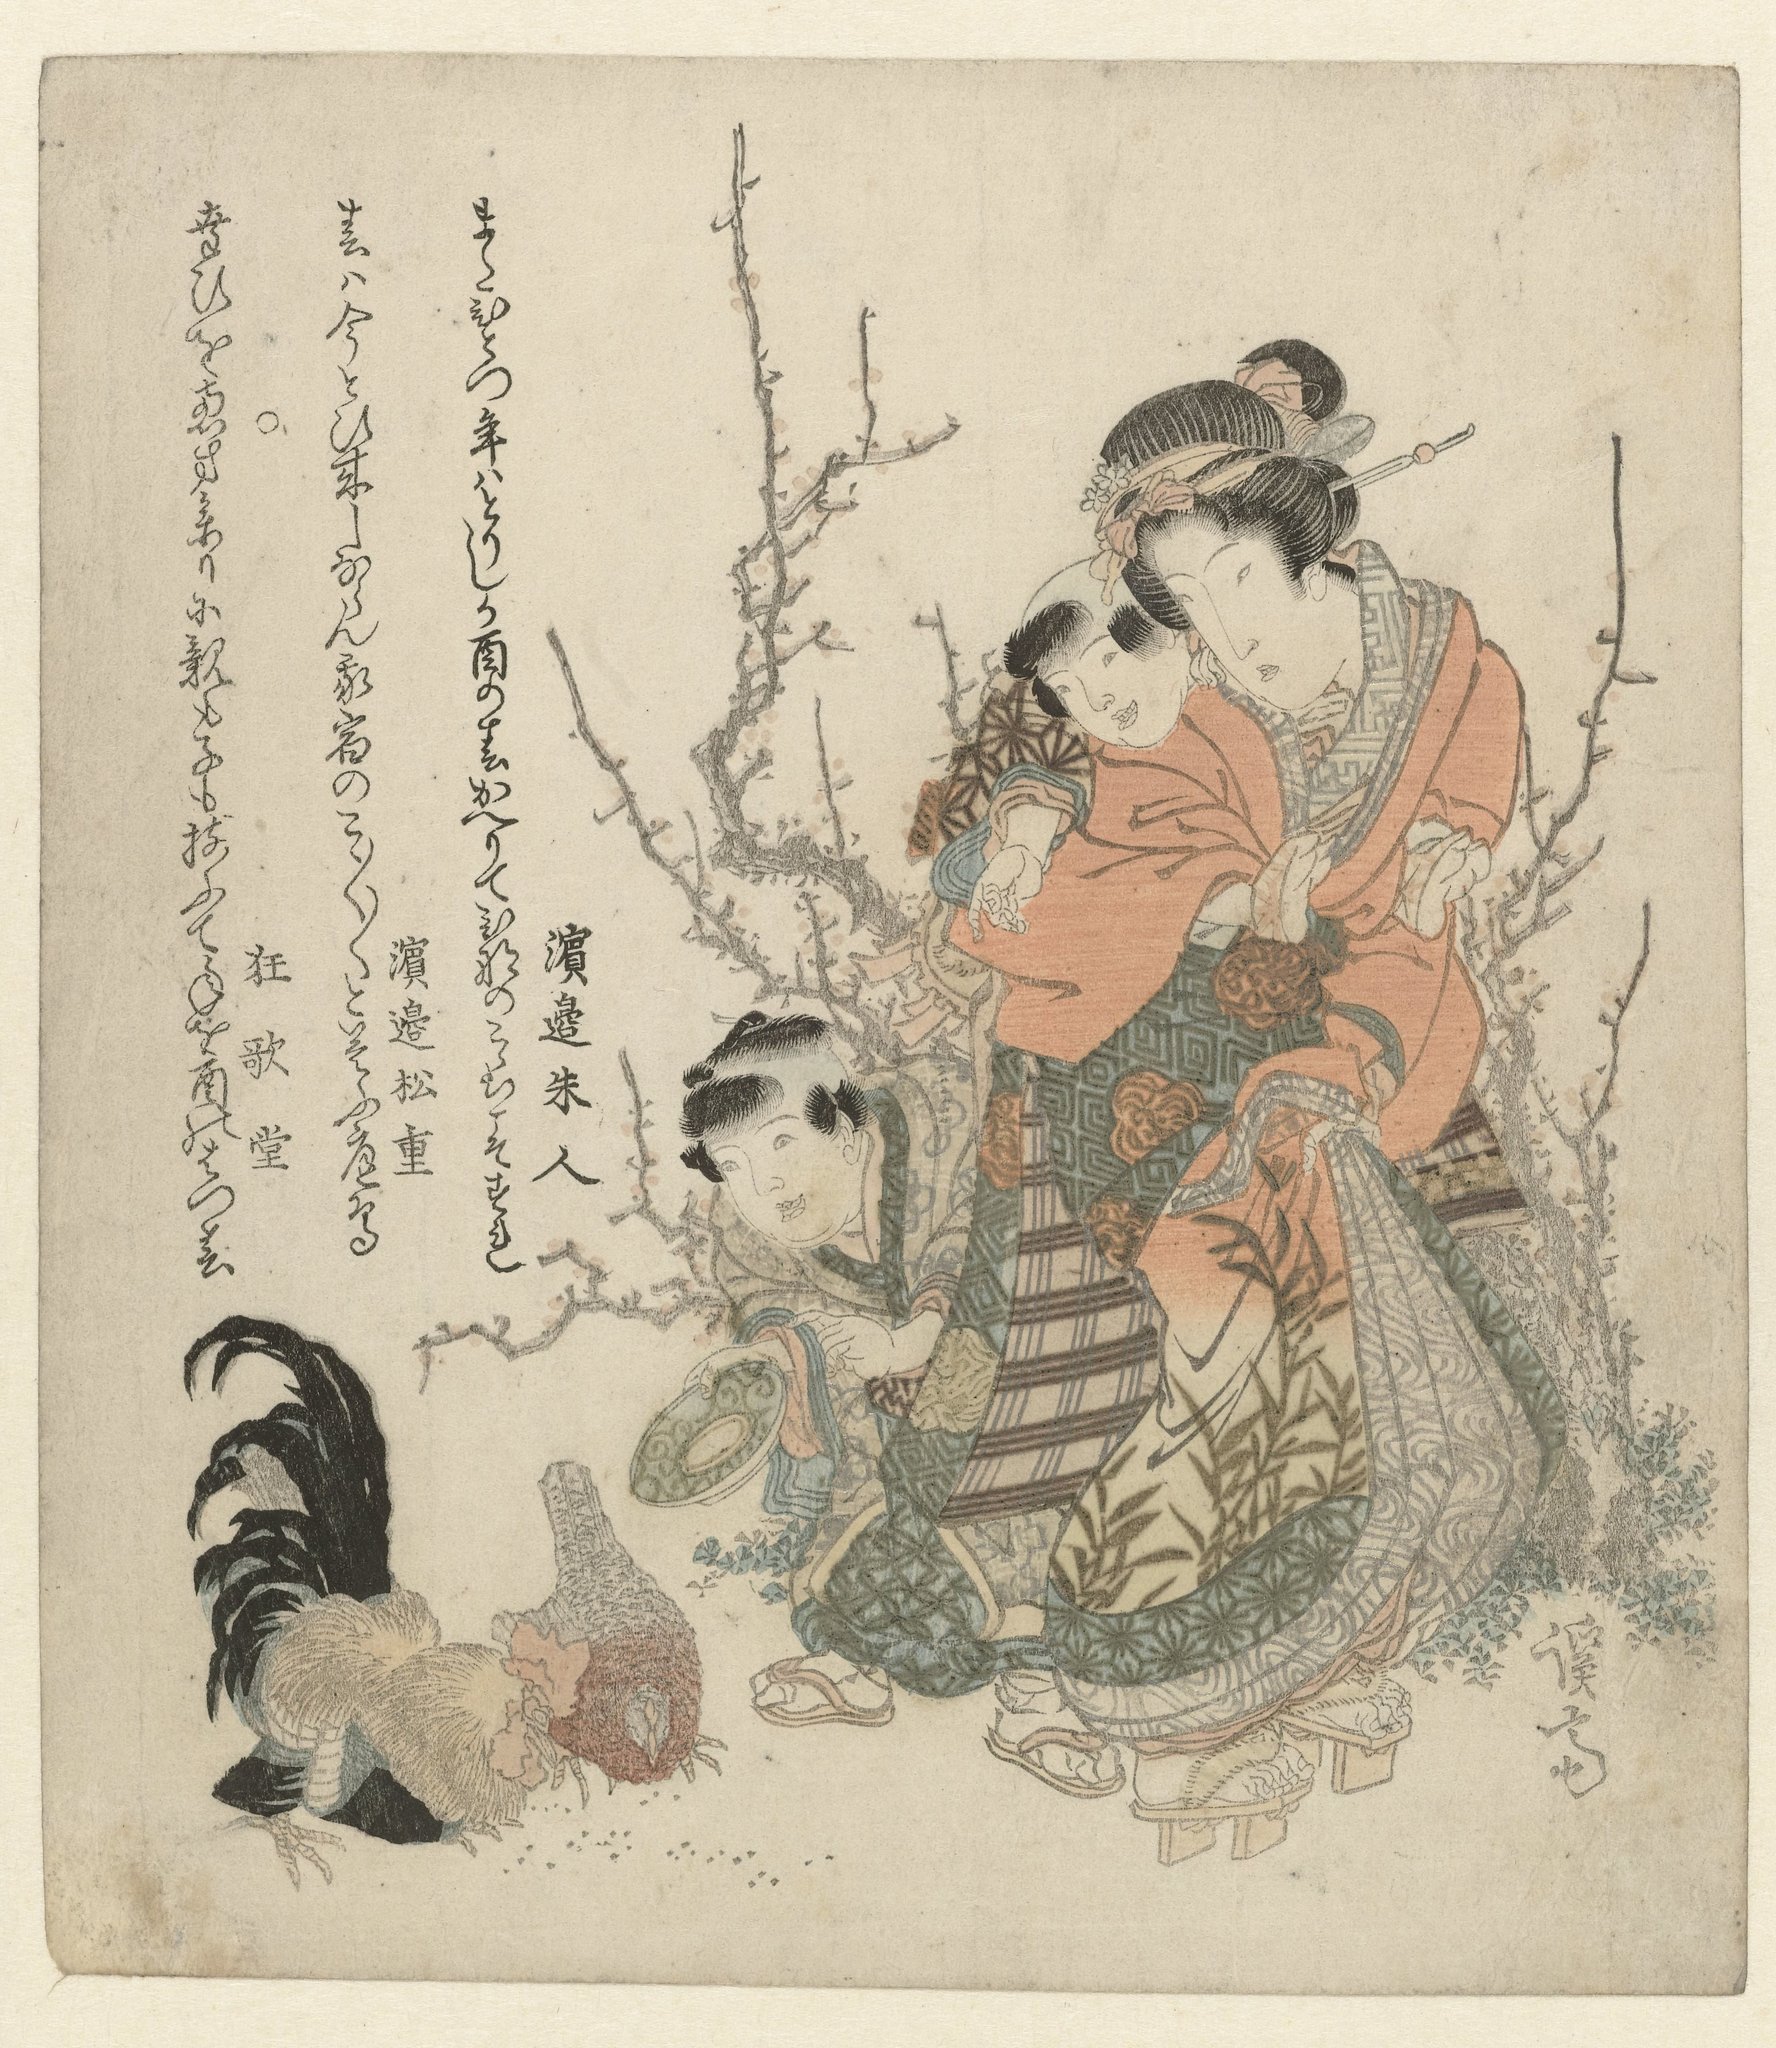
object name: surimono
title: Woman and Children Feeding Chicken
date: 1825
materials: paper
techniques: woodcut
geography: japan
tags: fowl (cock, hen, chicken, etc.) (+ feeding animal), mother and child(ren), woman and child(ren) (family group)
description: Een surimono is een luxe uitgevoerde prent waarop beeld met één of meerdere gedichten gecombineerd is. Bij het drukken van een surimono werd vaak gebruik gemaakt van dikker papier, blinddruk en metaal pigmenten, zoals koper- en zilverpoeder. De prenten werden vaak in opdracht van dichters gemaakt en als exclusief geschenk aan vrienden en relaties gegeven.